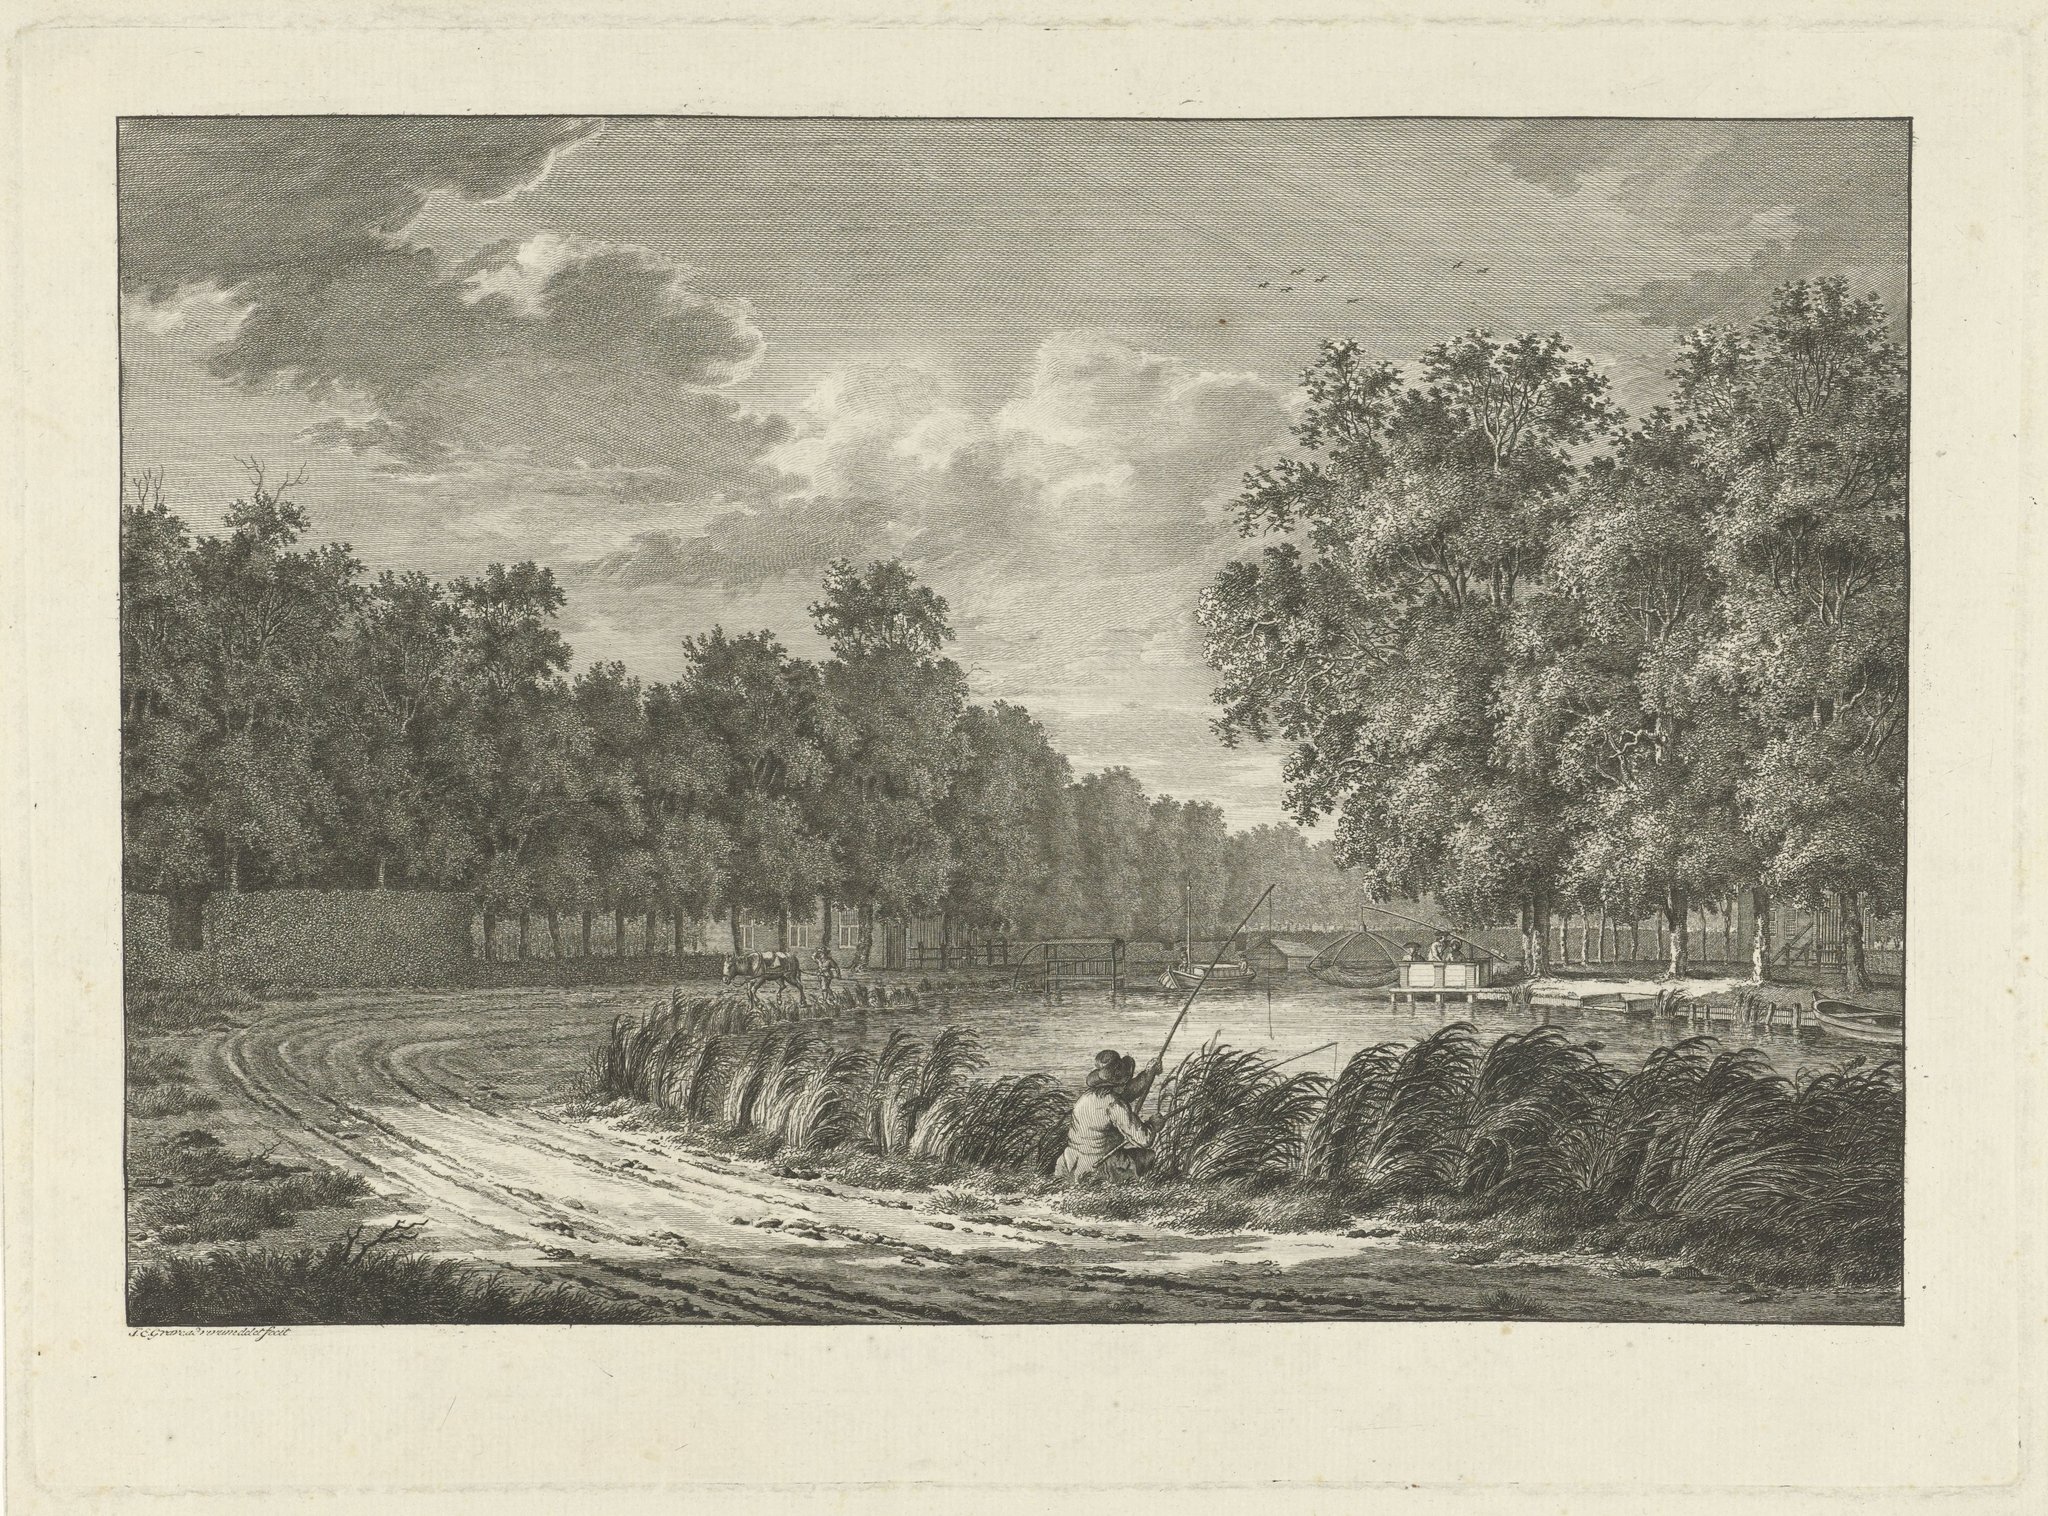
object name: print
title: Landschap met een visser aan de oever van het Gein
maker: jan evert grave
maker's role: draughtsman, print maker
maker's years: 1759-1805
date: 1769-1805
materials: paper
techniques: engraving, etching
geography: amsterdam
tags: hunter, river (+ landscape with figures, staffage), angling, fisherman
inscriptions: collector's mark: Lugt 2228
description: De oever van de rivier het Gein bij Amsterdam. Op de voorgrond een hengelaar langs de weg. Op de achtergrond loopt een jager naast zijn paard.